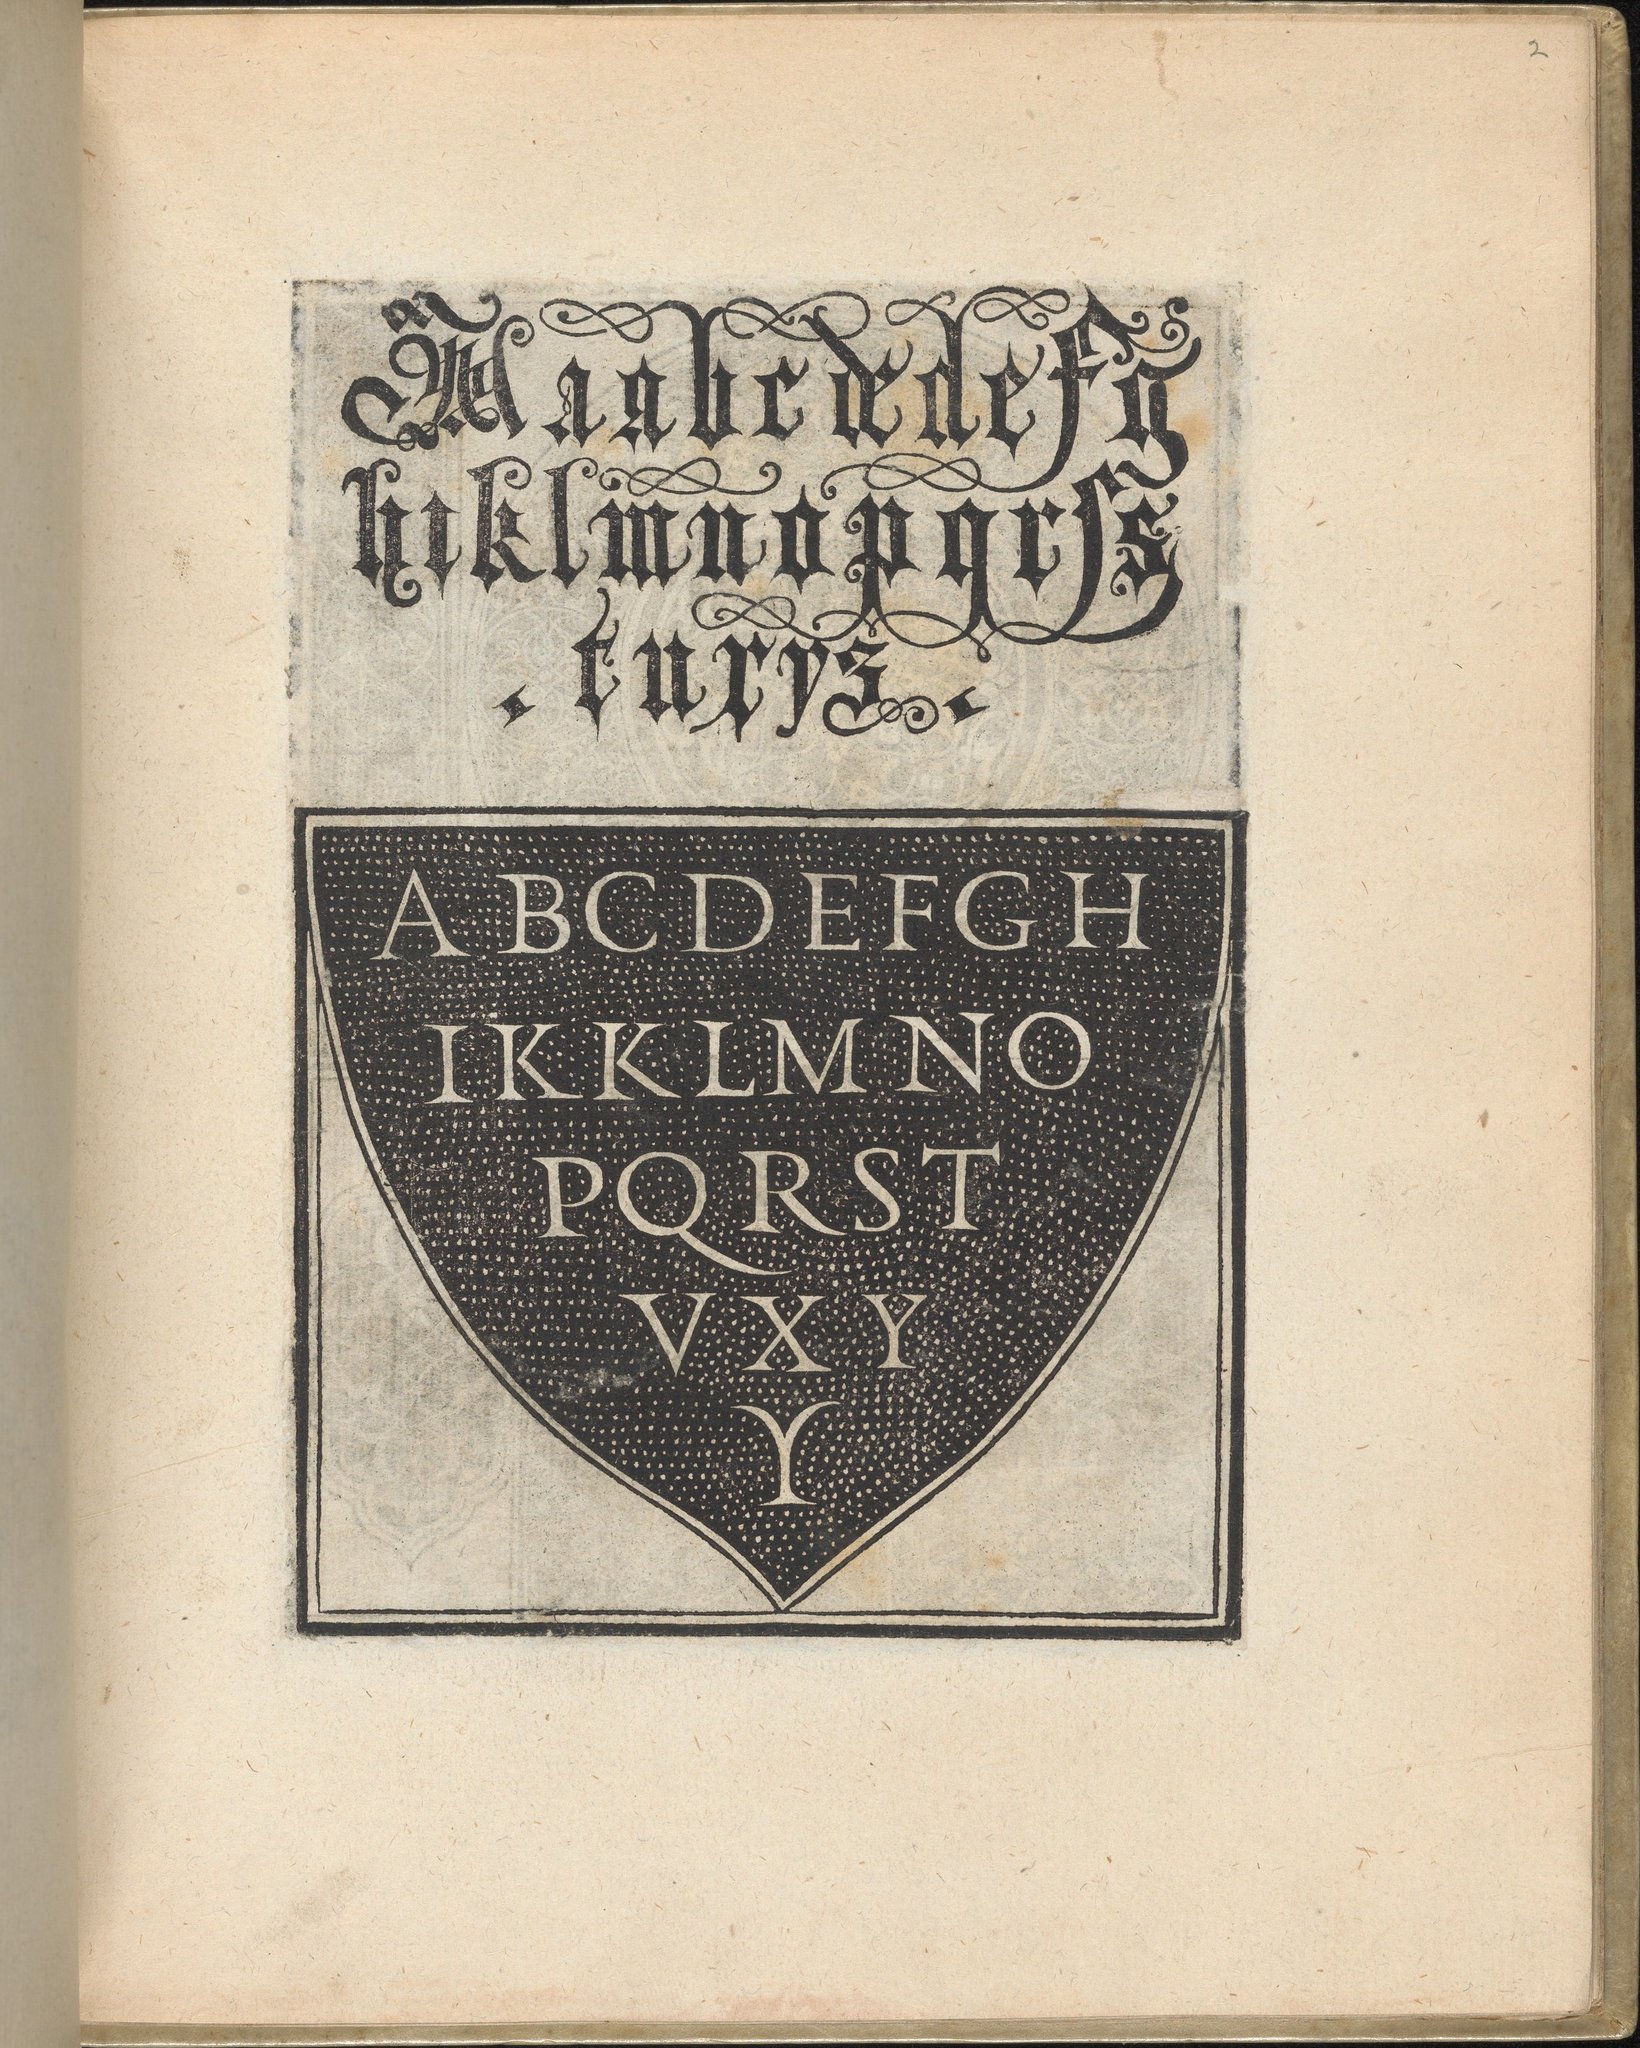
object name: book print ornament architecture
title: Trionfo Di Virtu. Libro Novo..., page 2 (recto)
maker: matteo pagano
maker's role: publisher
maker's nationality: italian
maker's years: 1515-1588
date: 1563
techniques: woodcut